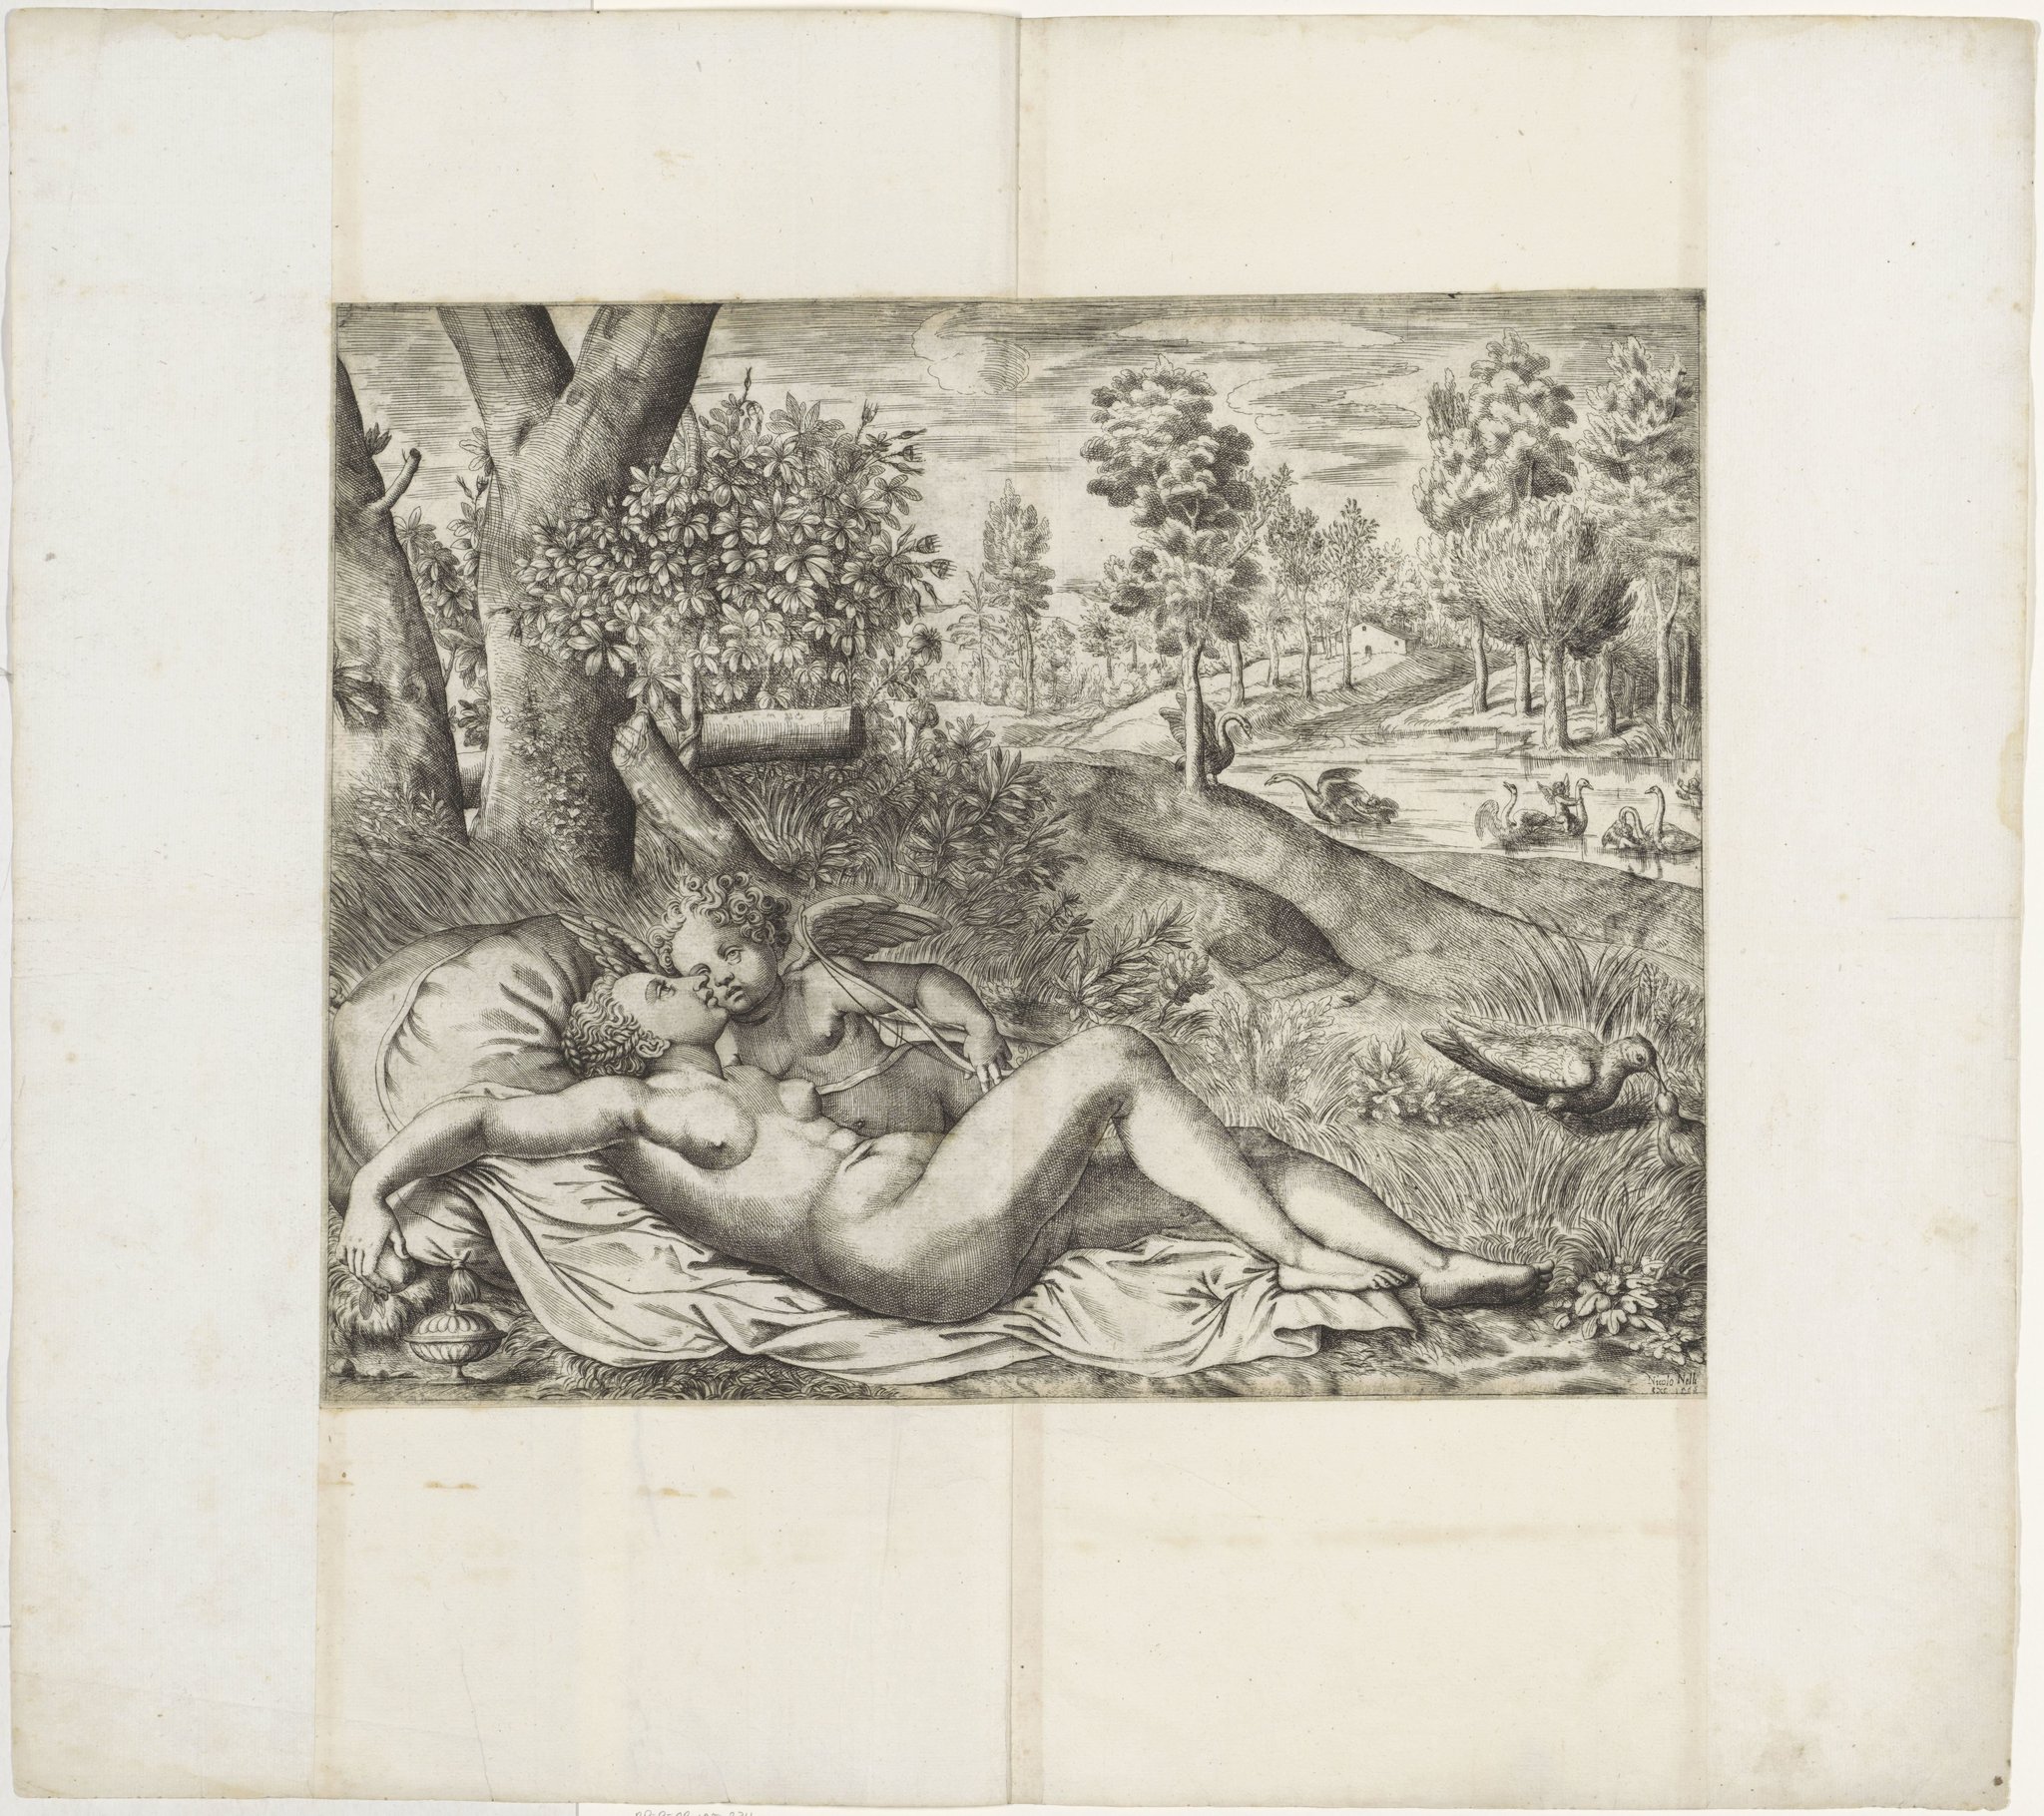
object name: album leaf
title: Venus en Amor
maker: niccolò nelli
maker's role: print maker, publisher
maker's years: 1535-1585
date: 1566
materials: paper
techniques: engraving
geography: venice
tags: venus and cupid (cupid not being mere attribute)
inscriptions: number: ‘28’, watermark, collector's mark: Lugt 2228, watermark, collector's mark: Lugt 2760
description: Folio 28 uit het prentalbum van Johann Georg I. Zobel von Giebelstadt (Röttingen 1543-07-20 - Bamberg 1580-09-07), de latere bisschop van Bamberg. Het album is vermoedelijk samengesteld tussen 1568 en 1570 in Venetië. Het album werd in 1999 uit elkaar genomen door een antiquair. De in totaal 124 folio's met prenten uit het "Zobel Album" werden aangekocht door verschillende musea en privéverzamelingen. De grootste groep (68 folio's) bevindt zich in de collectie van het Rijksmuseum.